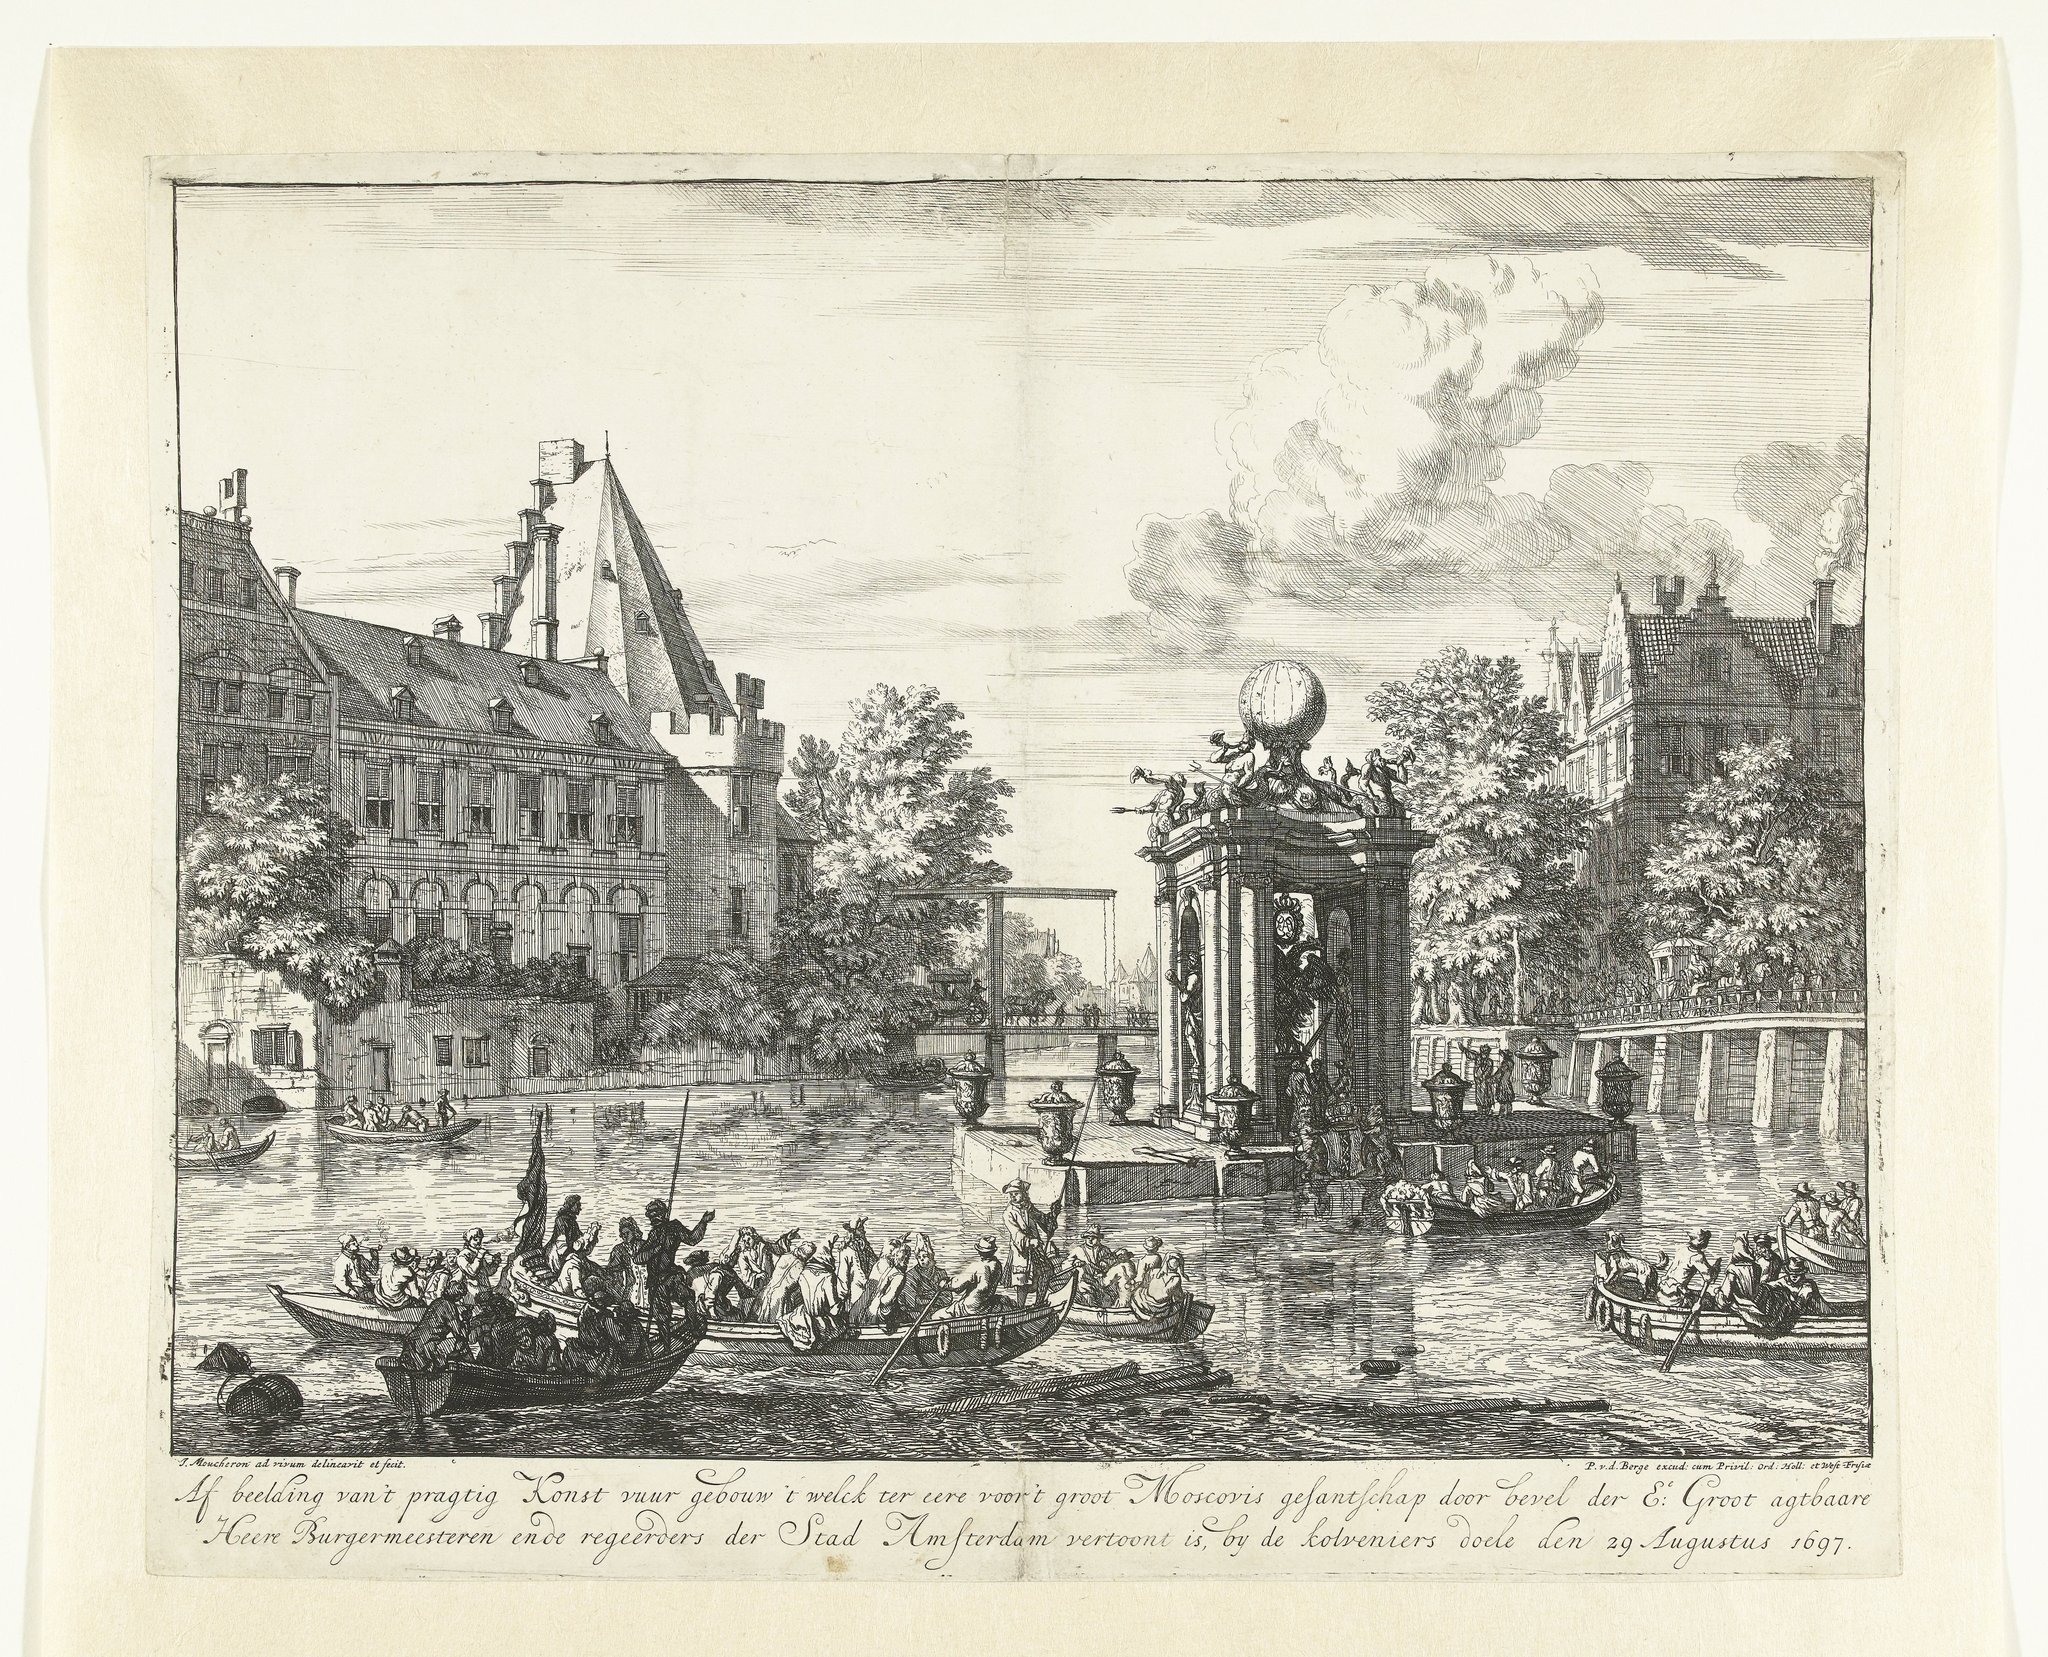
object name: print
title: Af beelding van 't pragtig Konst vuur gebouw 't welck ter eere voor 't groot Moscovis gesantschap door bevel der E. Groot agtbaare Heere Bugermeesteren ende regeerders der Stad Amsterdam vertoont is, by de kolveniers doele den 29 Augustus 1697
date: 1697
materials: paper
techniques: etching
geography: northern netherlands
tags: peter i de grote (tsaar van rusland), bonfire, fire-works, festivities (+ illumination, fire-works ~ festive activities)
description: Gebouw voor het vuurwerk gegeven door het stadsbestuur ter ere van het bezoek van het Russisch gezantschap met tsaar Peter de Grote aan Amsterdam, 29 augustus 1697. Stellage opgericht in het water bij de Kloveniersdoelen en Kloveniersburgwal.